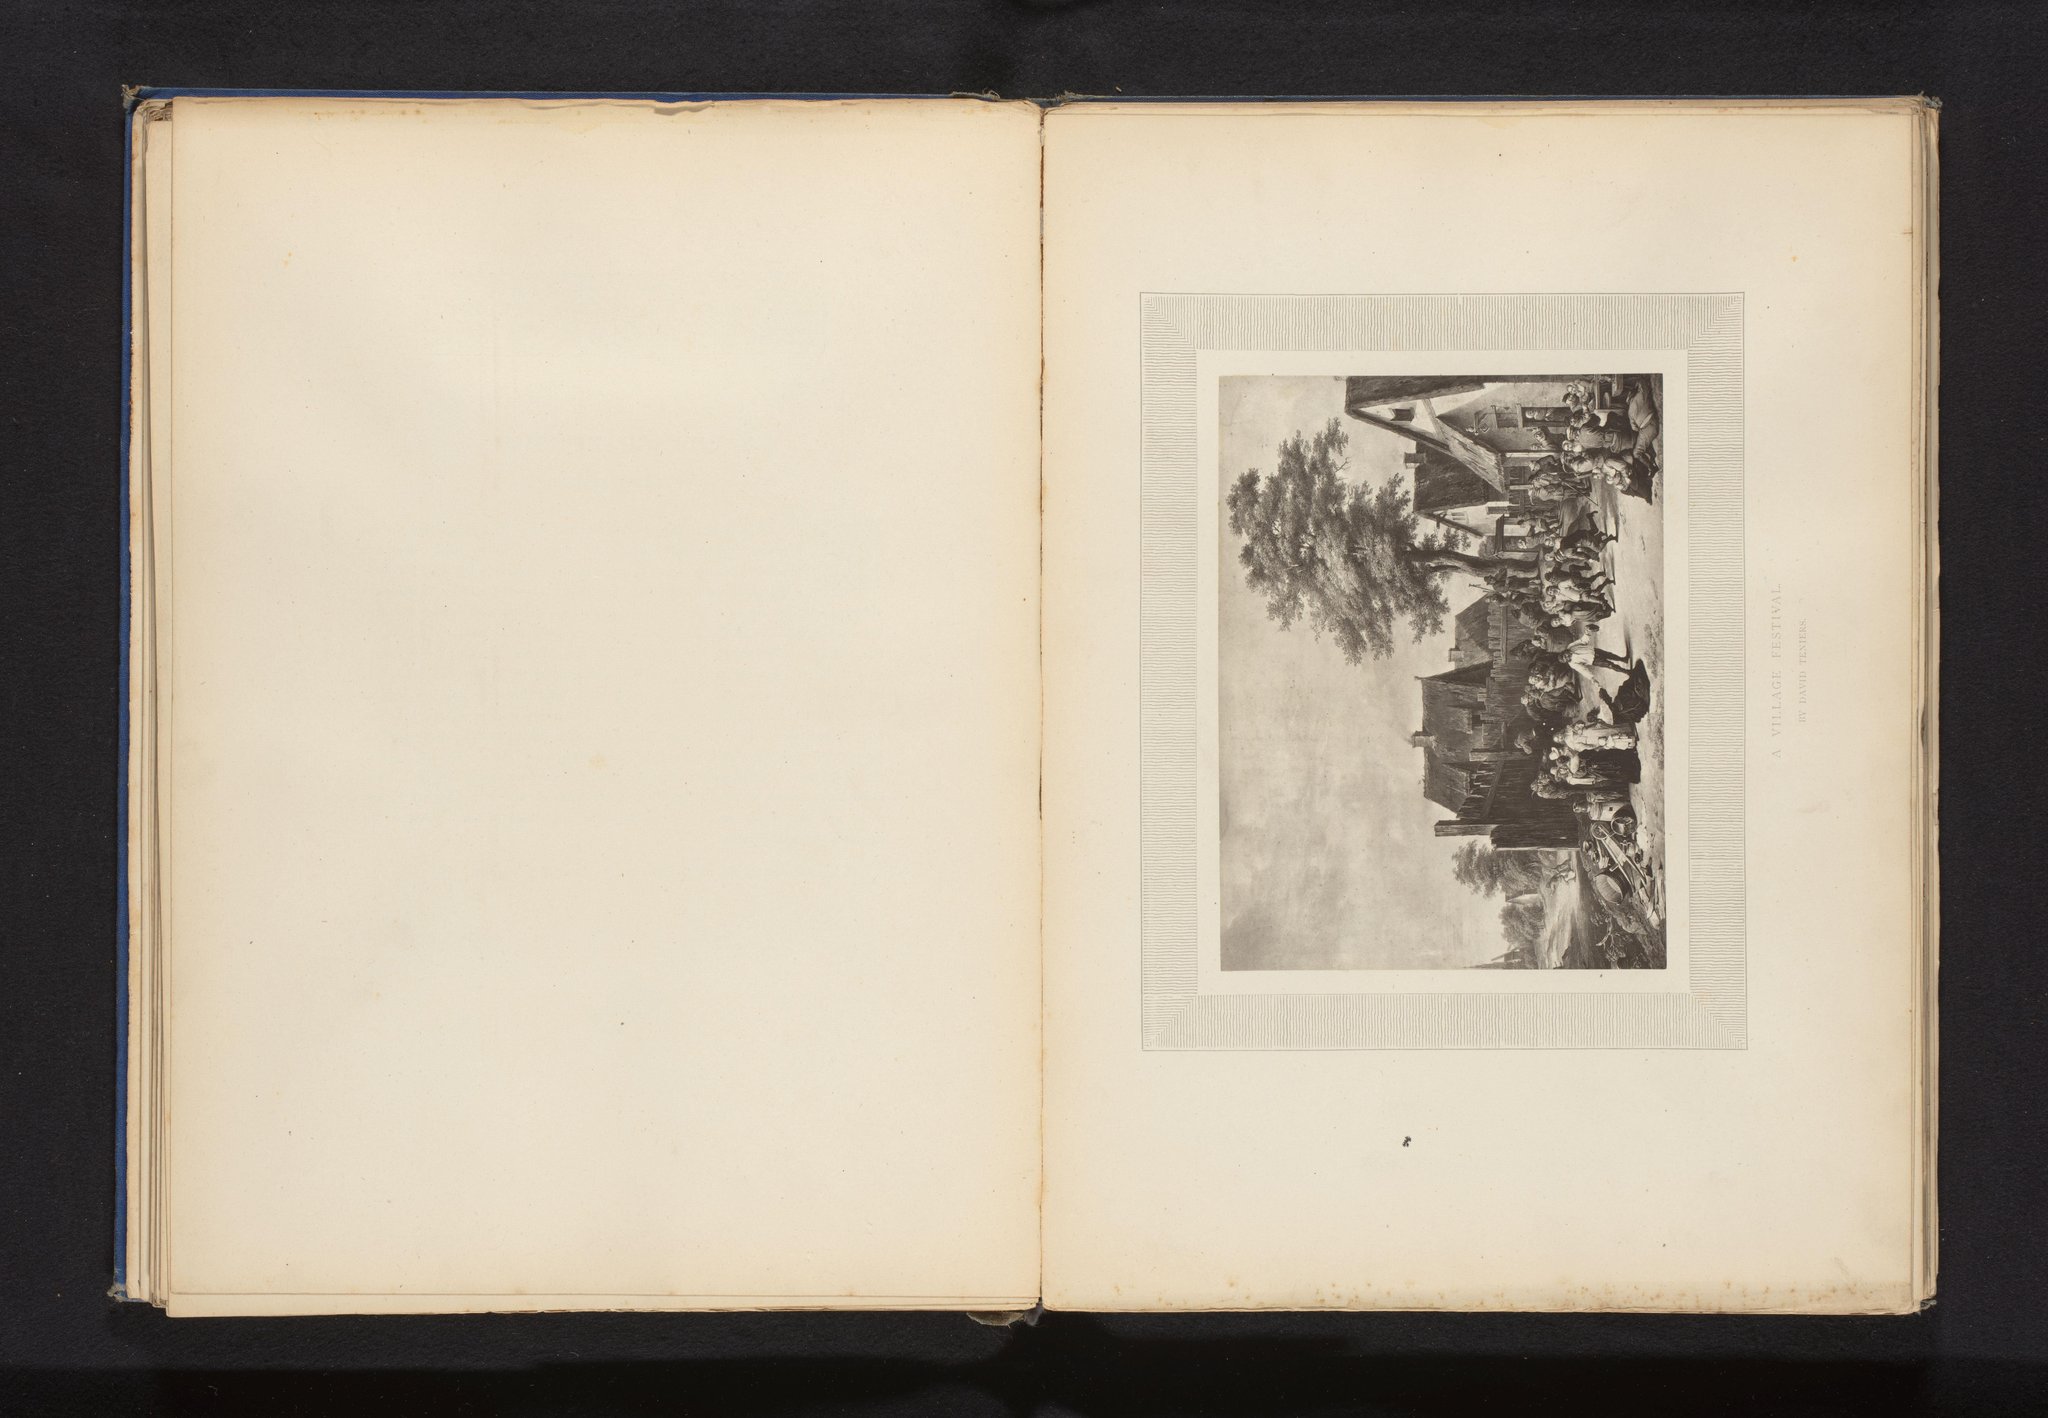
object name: reproduction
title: A village festival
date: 1870-1875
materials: paper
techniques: woodburytype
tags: public festivities, village (+ city(-scape) with figures, staffage)